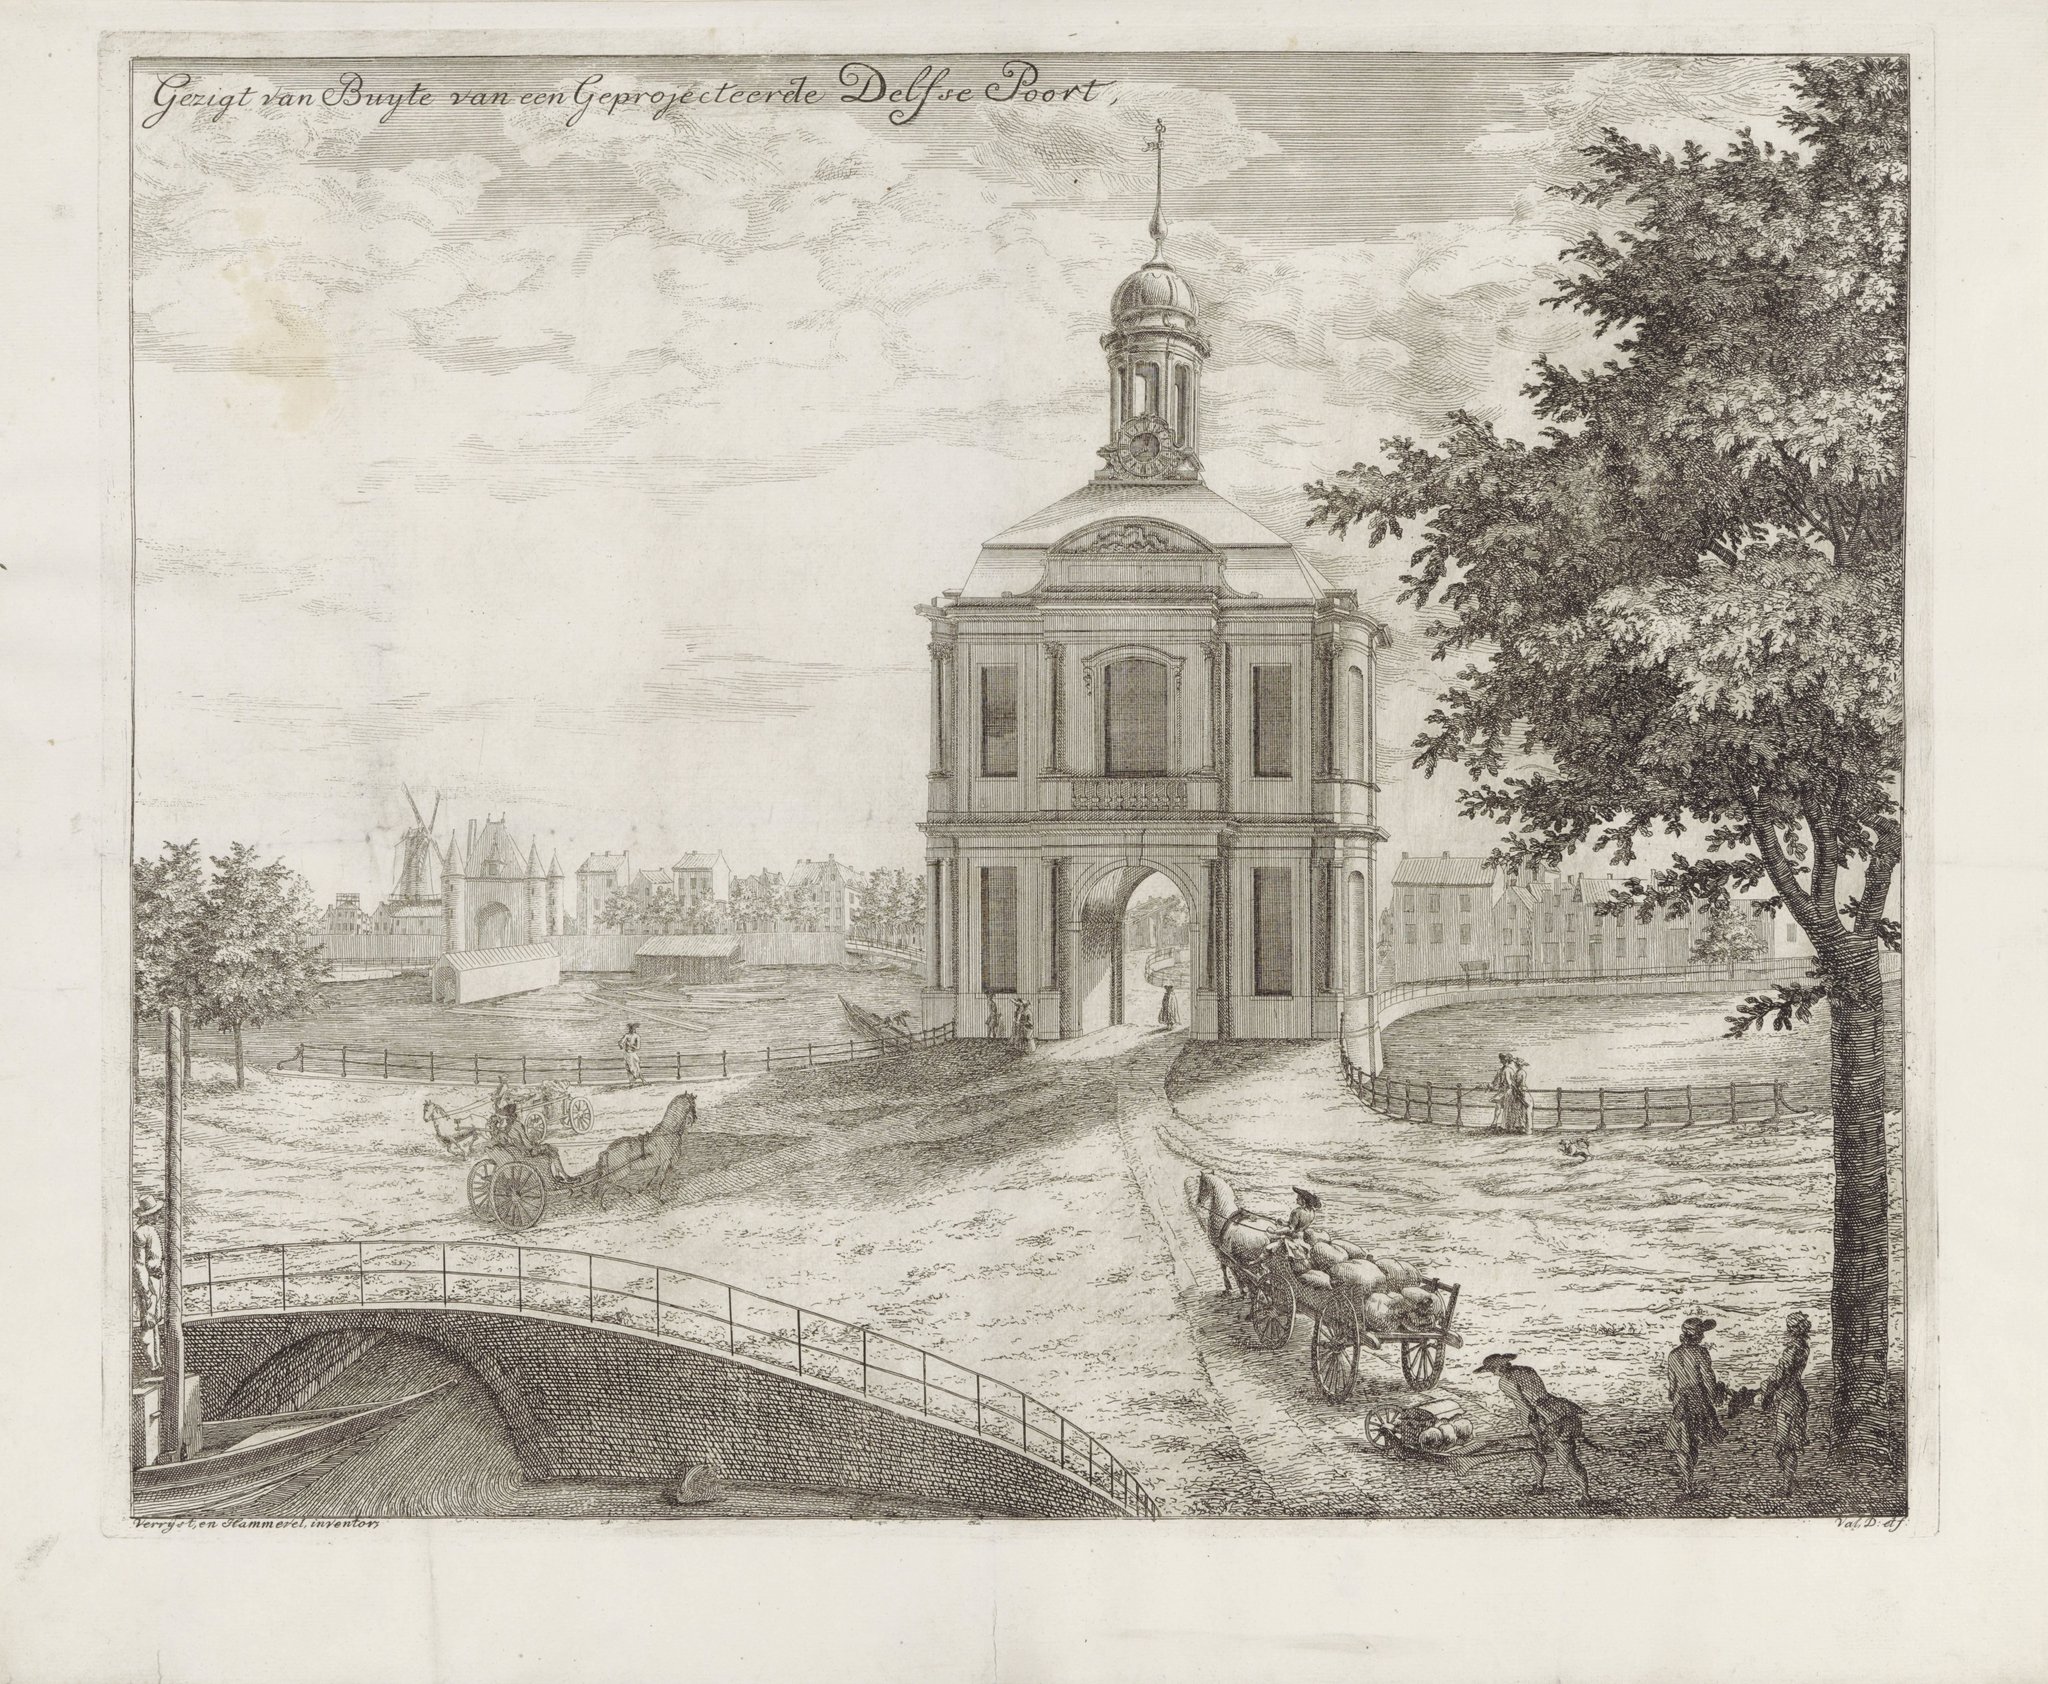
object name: print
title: Ontwerp voor een nieuwe Delftse Poort te Rotterdam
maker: auguste moreau val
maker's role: draughtsman, print maker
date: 1767-1769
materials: paper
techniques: etching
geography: netherlands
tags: wheelbarrow, city-gate, (farm) wagon, freight wagon, cart, rotterdam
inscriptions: collector's mark: Lugt 2228, collector's mark: Lugt 2760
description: Ontwerp voor de nieuwe Delftse poort te Rotterdam, met op de voorgrond een molenaarskar, een man met een kruiwagen en een paar wandelaars.